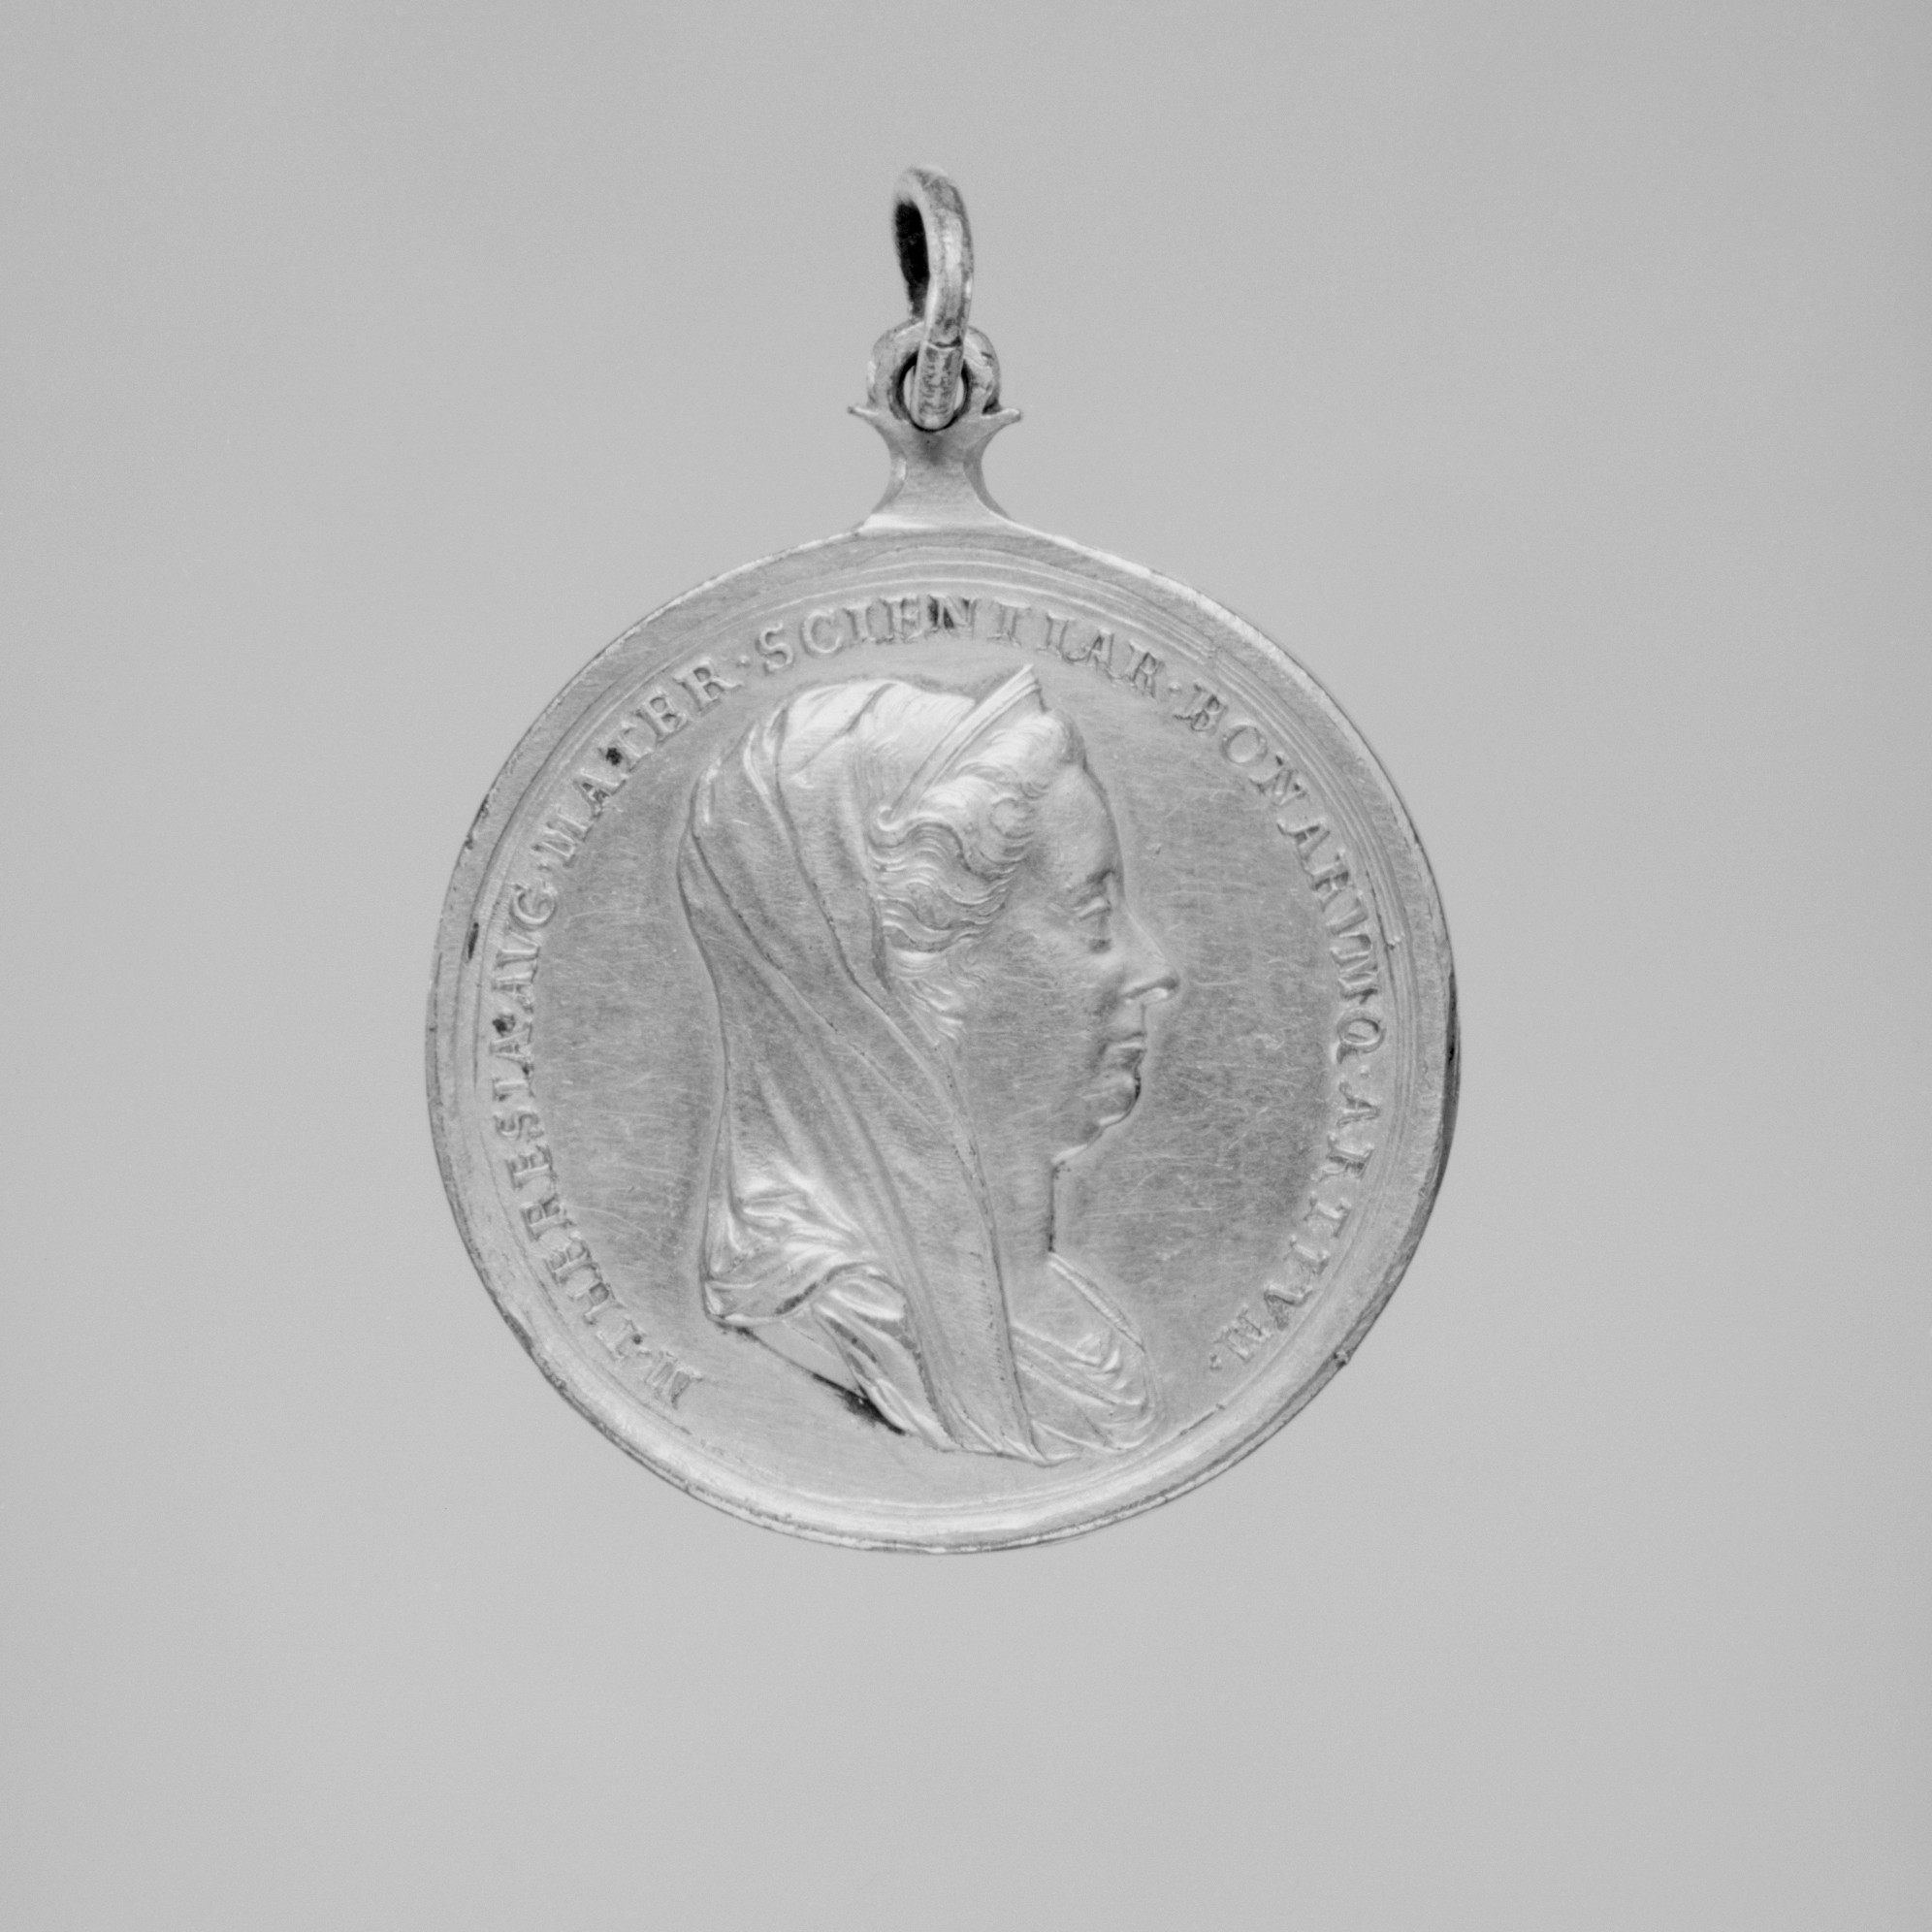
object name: medal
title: Amelioration of the Study of Latin in Public Schools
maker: anton franz widemann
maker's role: artist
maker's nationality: austrian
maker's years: 1724-1792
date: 1774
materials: gilt bronze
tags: profiles,women